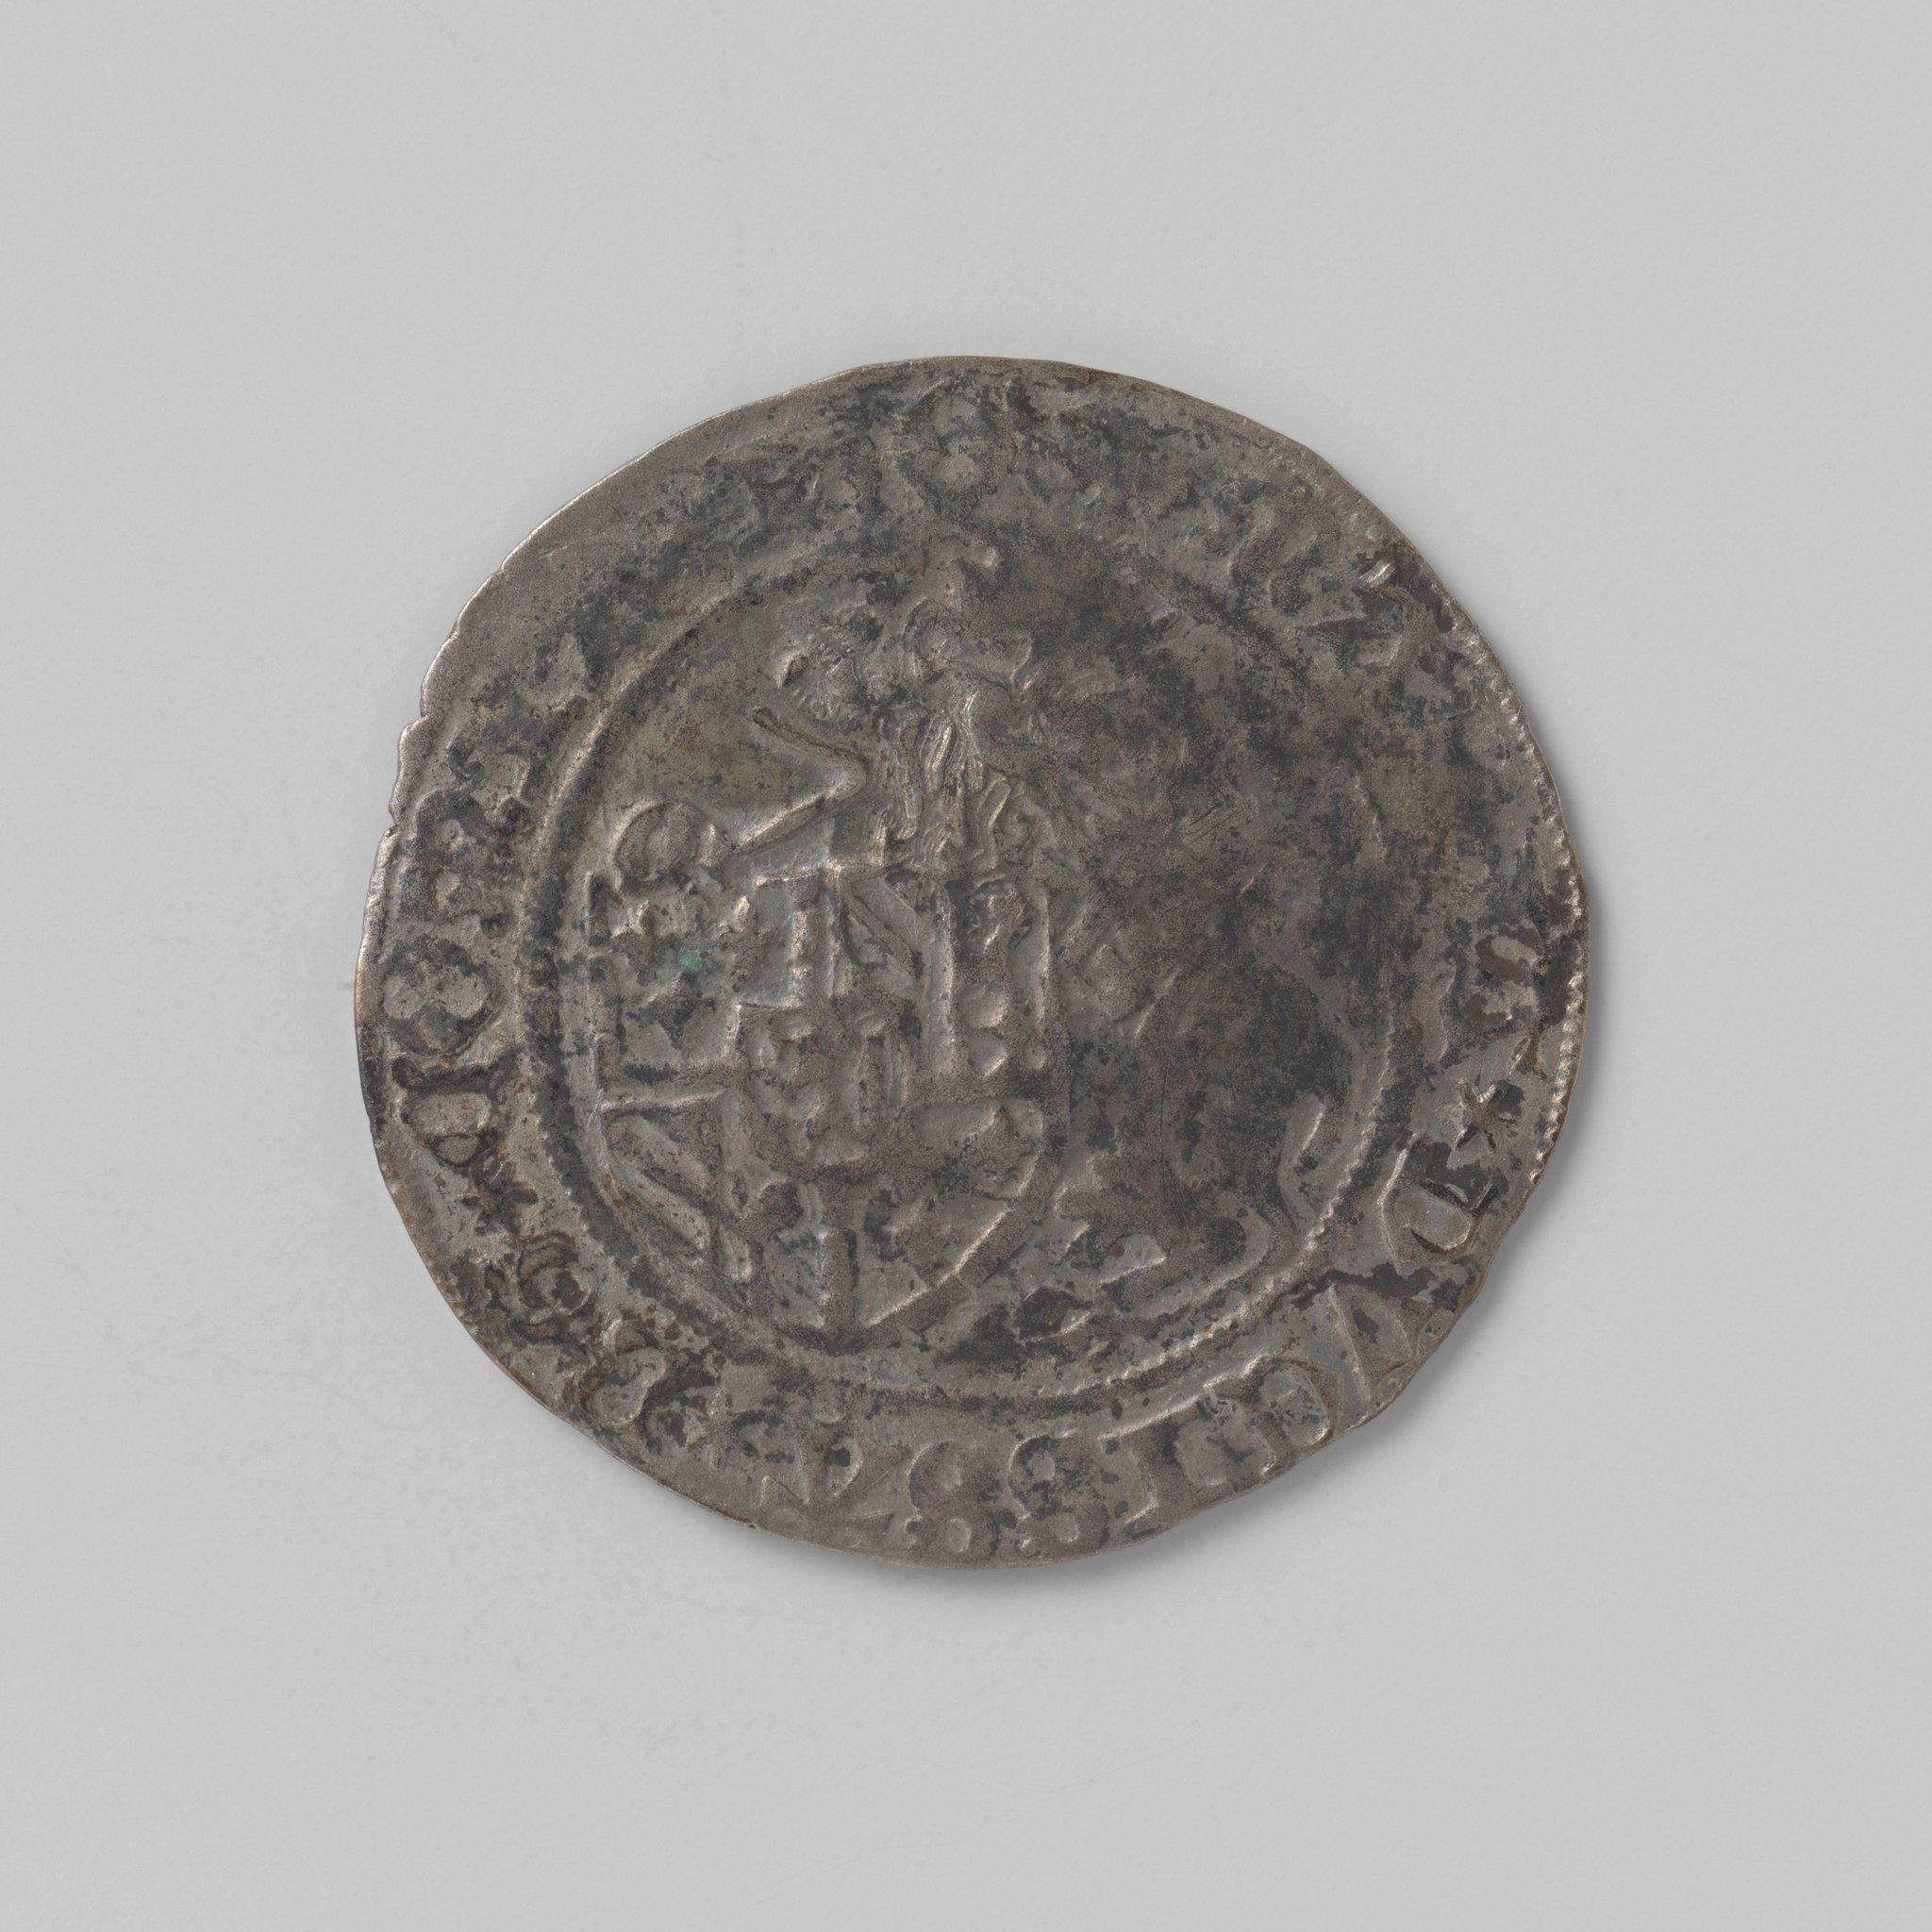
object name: coin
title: Holland, Maria van Bourgondië, vuurijzer, 1481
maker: maria (hertogin van bourgondië)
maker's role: hertogin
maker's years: 1457-1482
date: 1481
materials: silver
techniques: striking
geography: dordrecht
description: Zilveren munt. Voorzijde: zittende leeuw naar links, voor zich wapenschild van Maria. In het veld bloempje. Keerzijde: kort gebloemd kruis, in het hart roos.